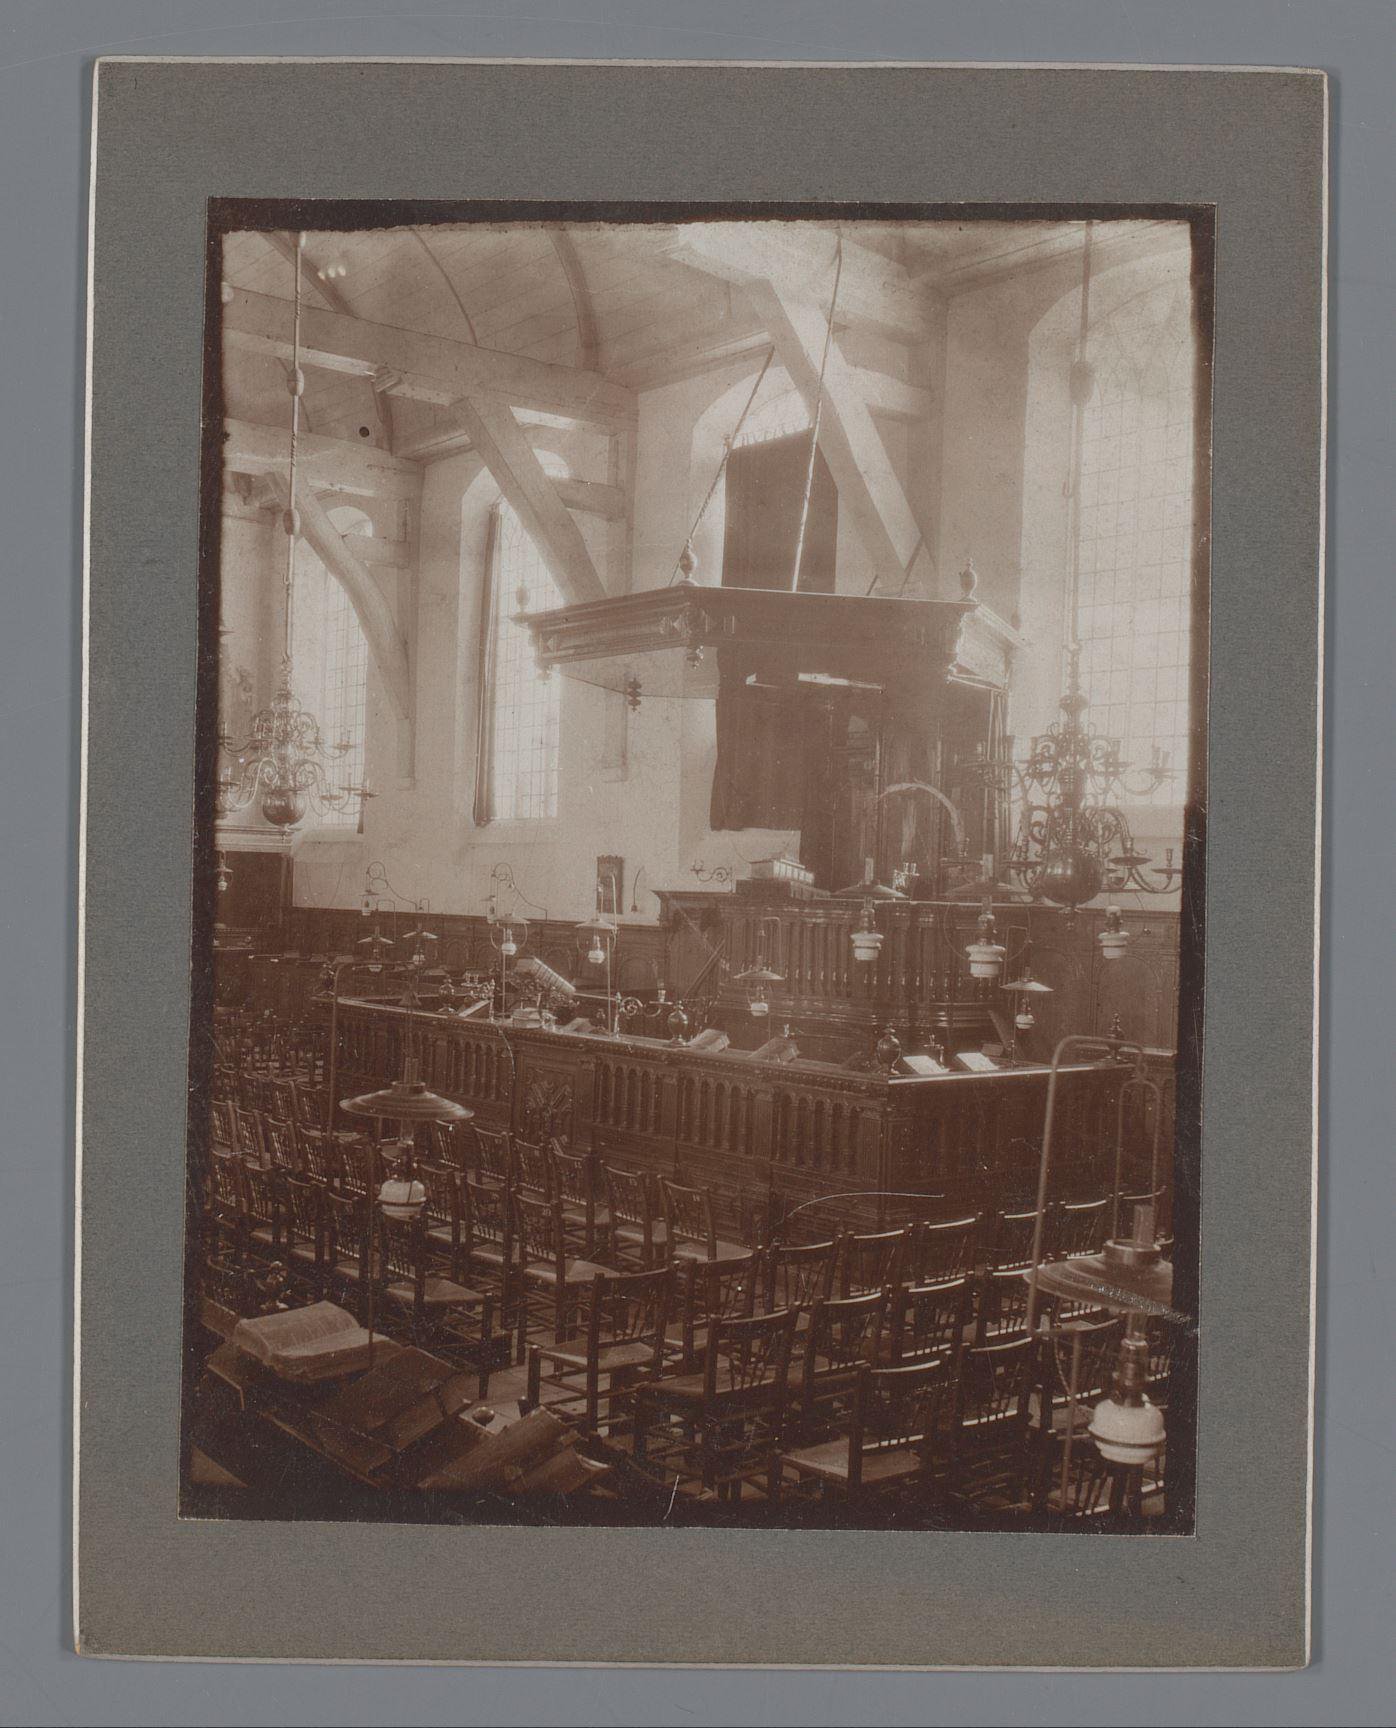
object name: photograph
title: Interieur van de Oude Kerk in Maasland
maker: Anonymous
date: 1880-1910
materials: paper, cardboard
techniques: collodion silver print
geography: maasland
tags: interior of church